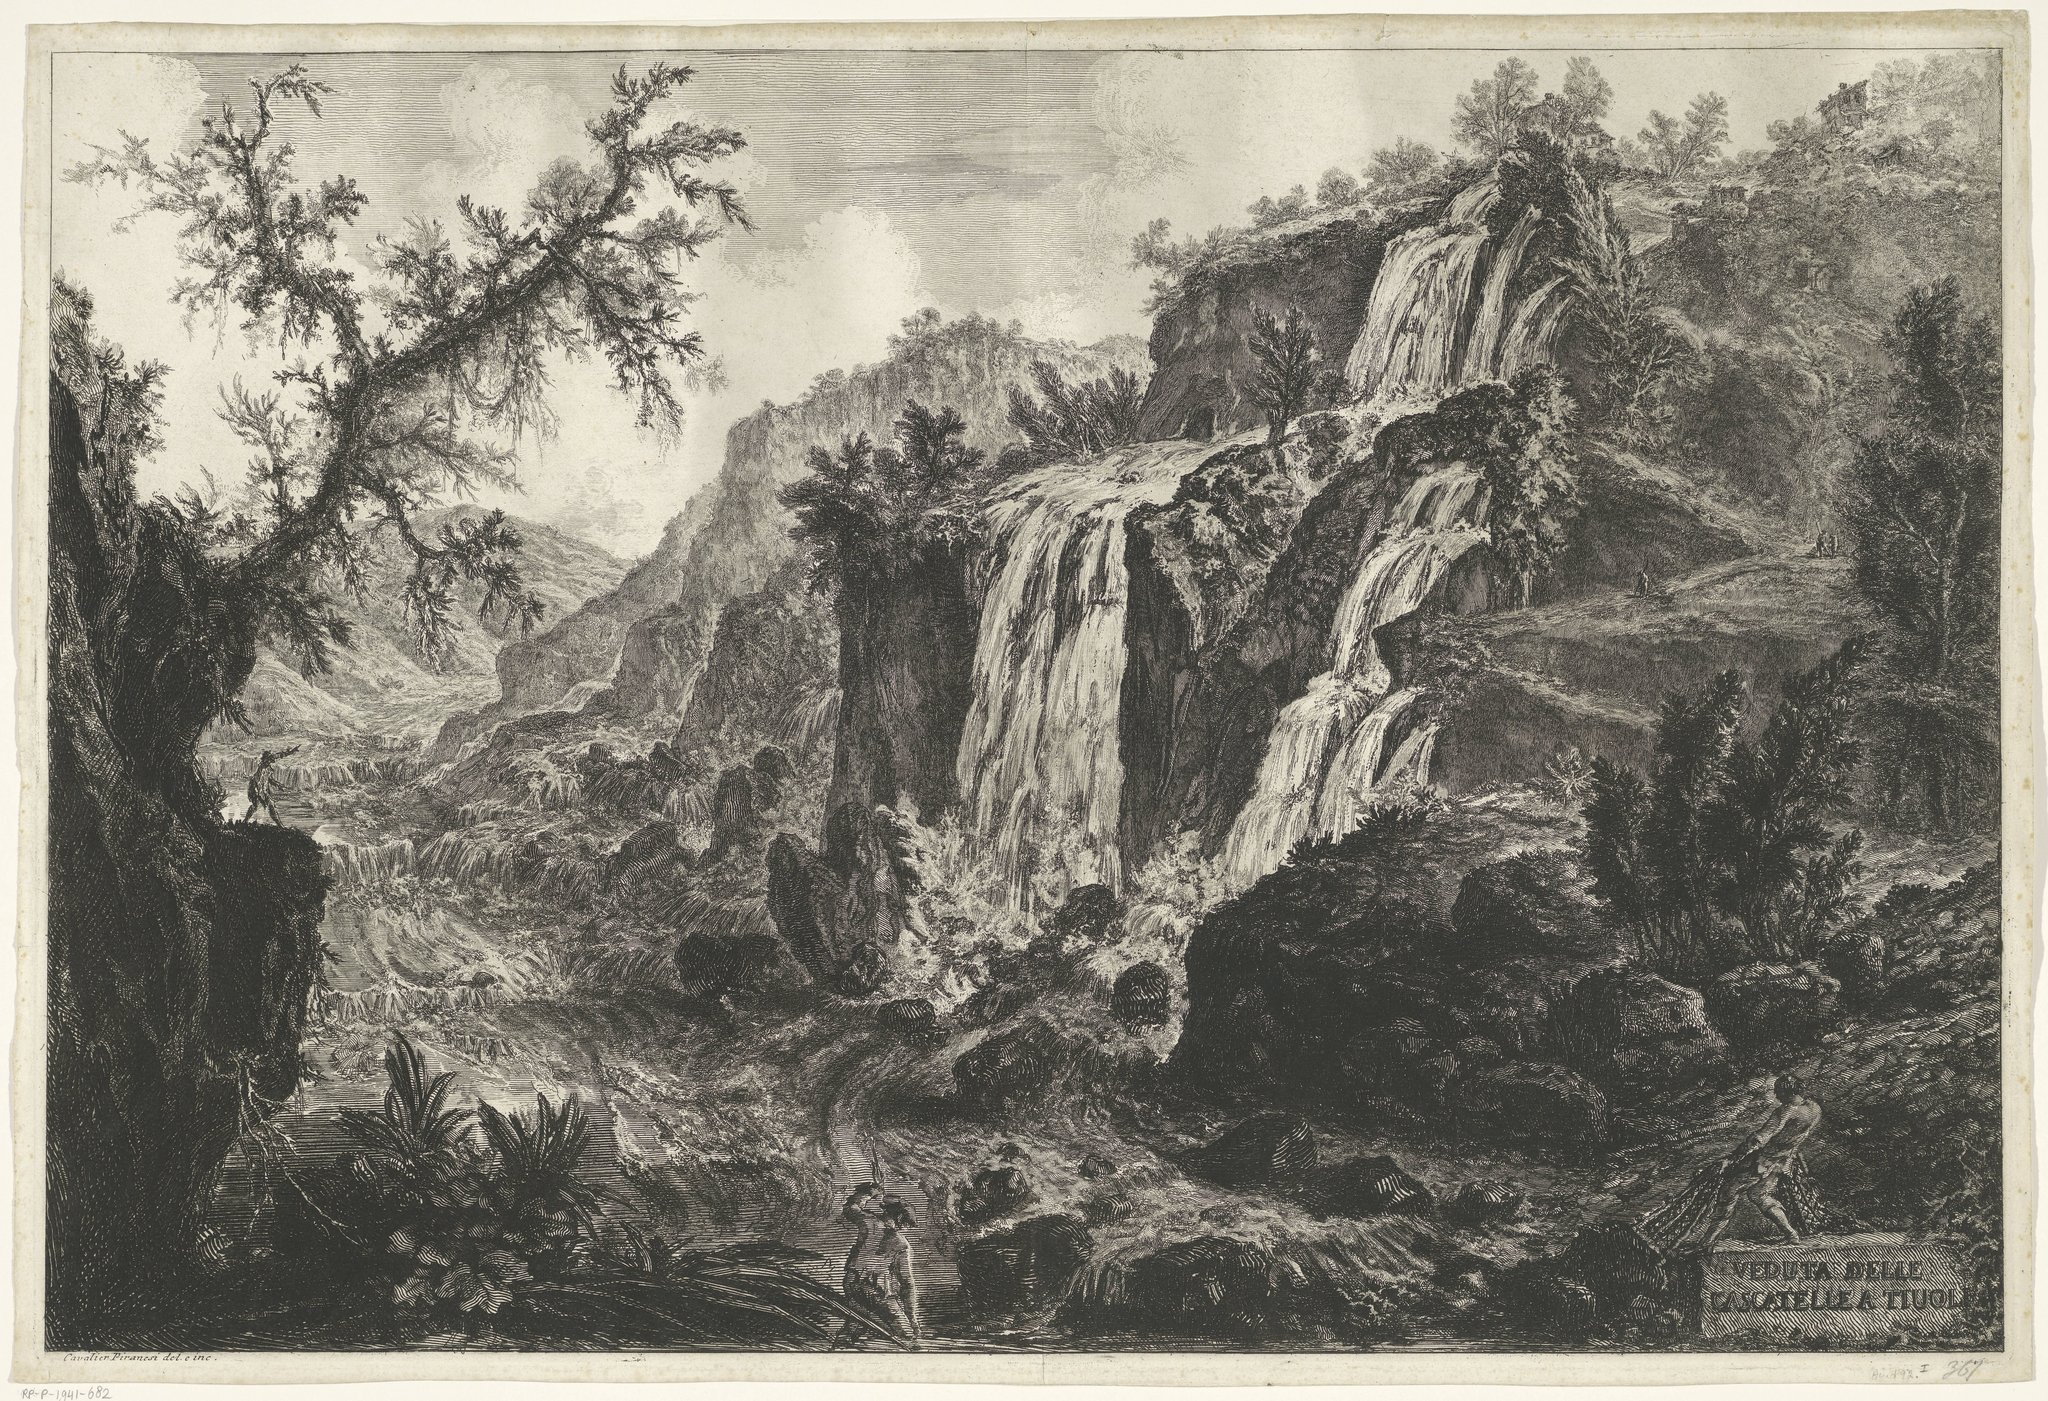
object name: print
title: Vedute di Roma disegnate ed incise da Giambattista Piranesi architetto Ve(nez)iano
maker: giovanni battista piranesi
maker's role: designer, draughtsman, print maker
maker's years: 1720-1778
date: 1748-1778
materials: paper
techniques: etching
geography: rome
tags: rapids, waterfall, tivoli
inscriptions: collector's mark: Lugt 2228, number: ‘110’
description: Deze prent maakt deel uit van de serie 'Vedute di Roma'. Piranesi werkte aan deze 135 platen tellende serie tussen 1748 en zijn dood in 1778. Francesco Piranesi voegde later nog twee prenten toe aan de reeks van zijn vader.